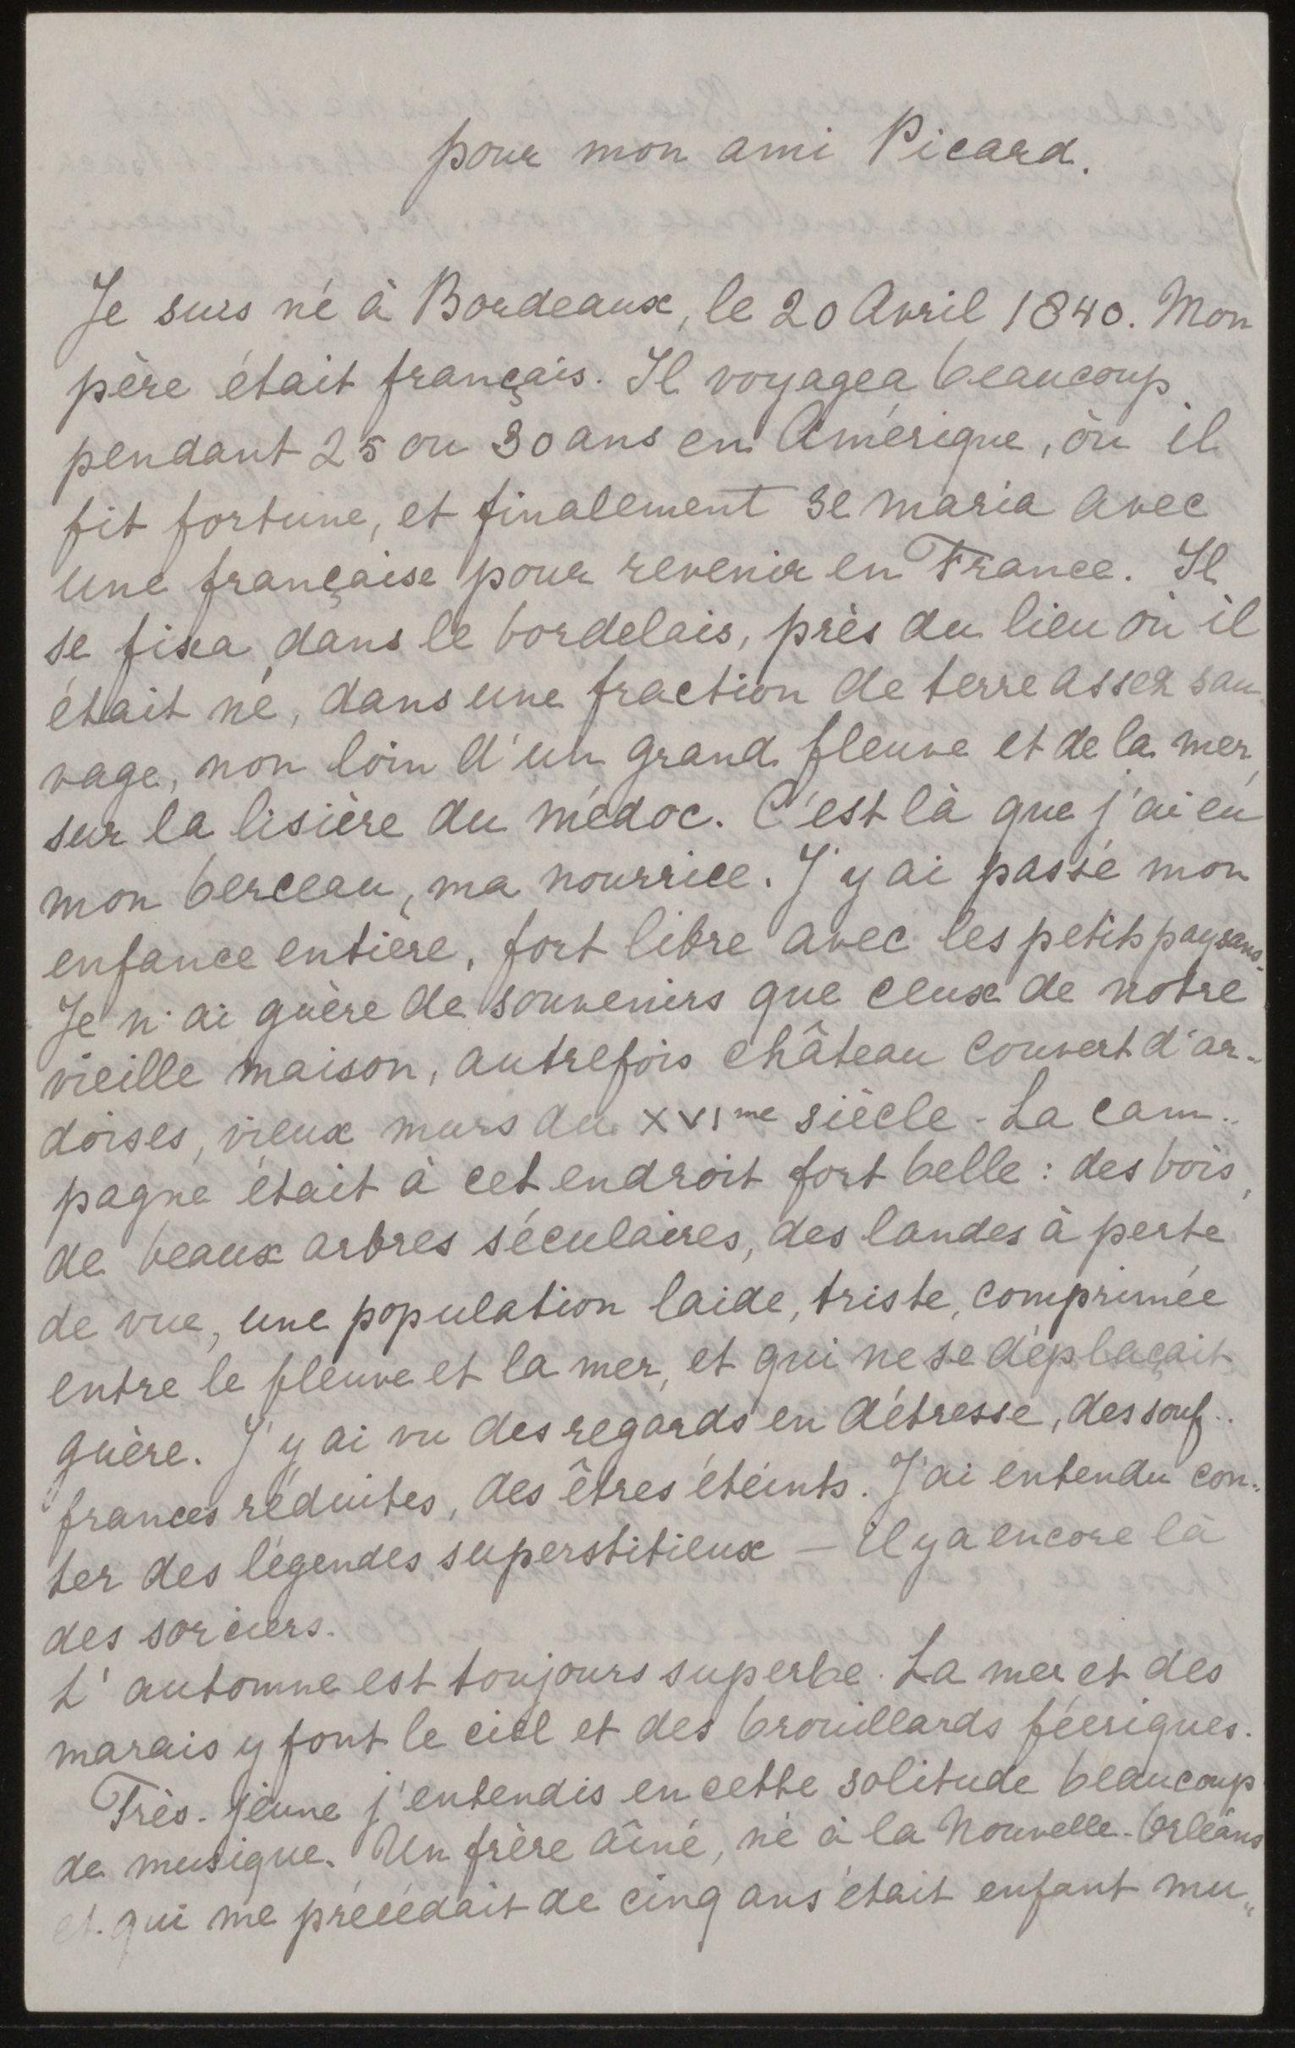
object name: letter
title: Brief aan Edmond Picard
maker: odilon redon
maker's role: draughtsman, painter, print maker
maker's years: 1840-1916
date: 1894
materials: ink, paper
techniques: pen, writing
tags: edmond picard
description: Brief behoort tot een album samengesteld door weduwe Françoise W.M. Barones van der Borch van Verwolde met afschriften van brieven met betrekking tot (de familie van) Odilon Redon. De brief werd bewaard op de achterzijde van het schutblad.